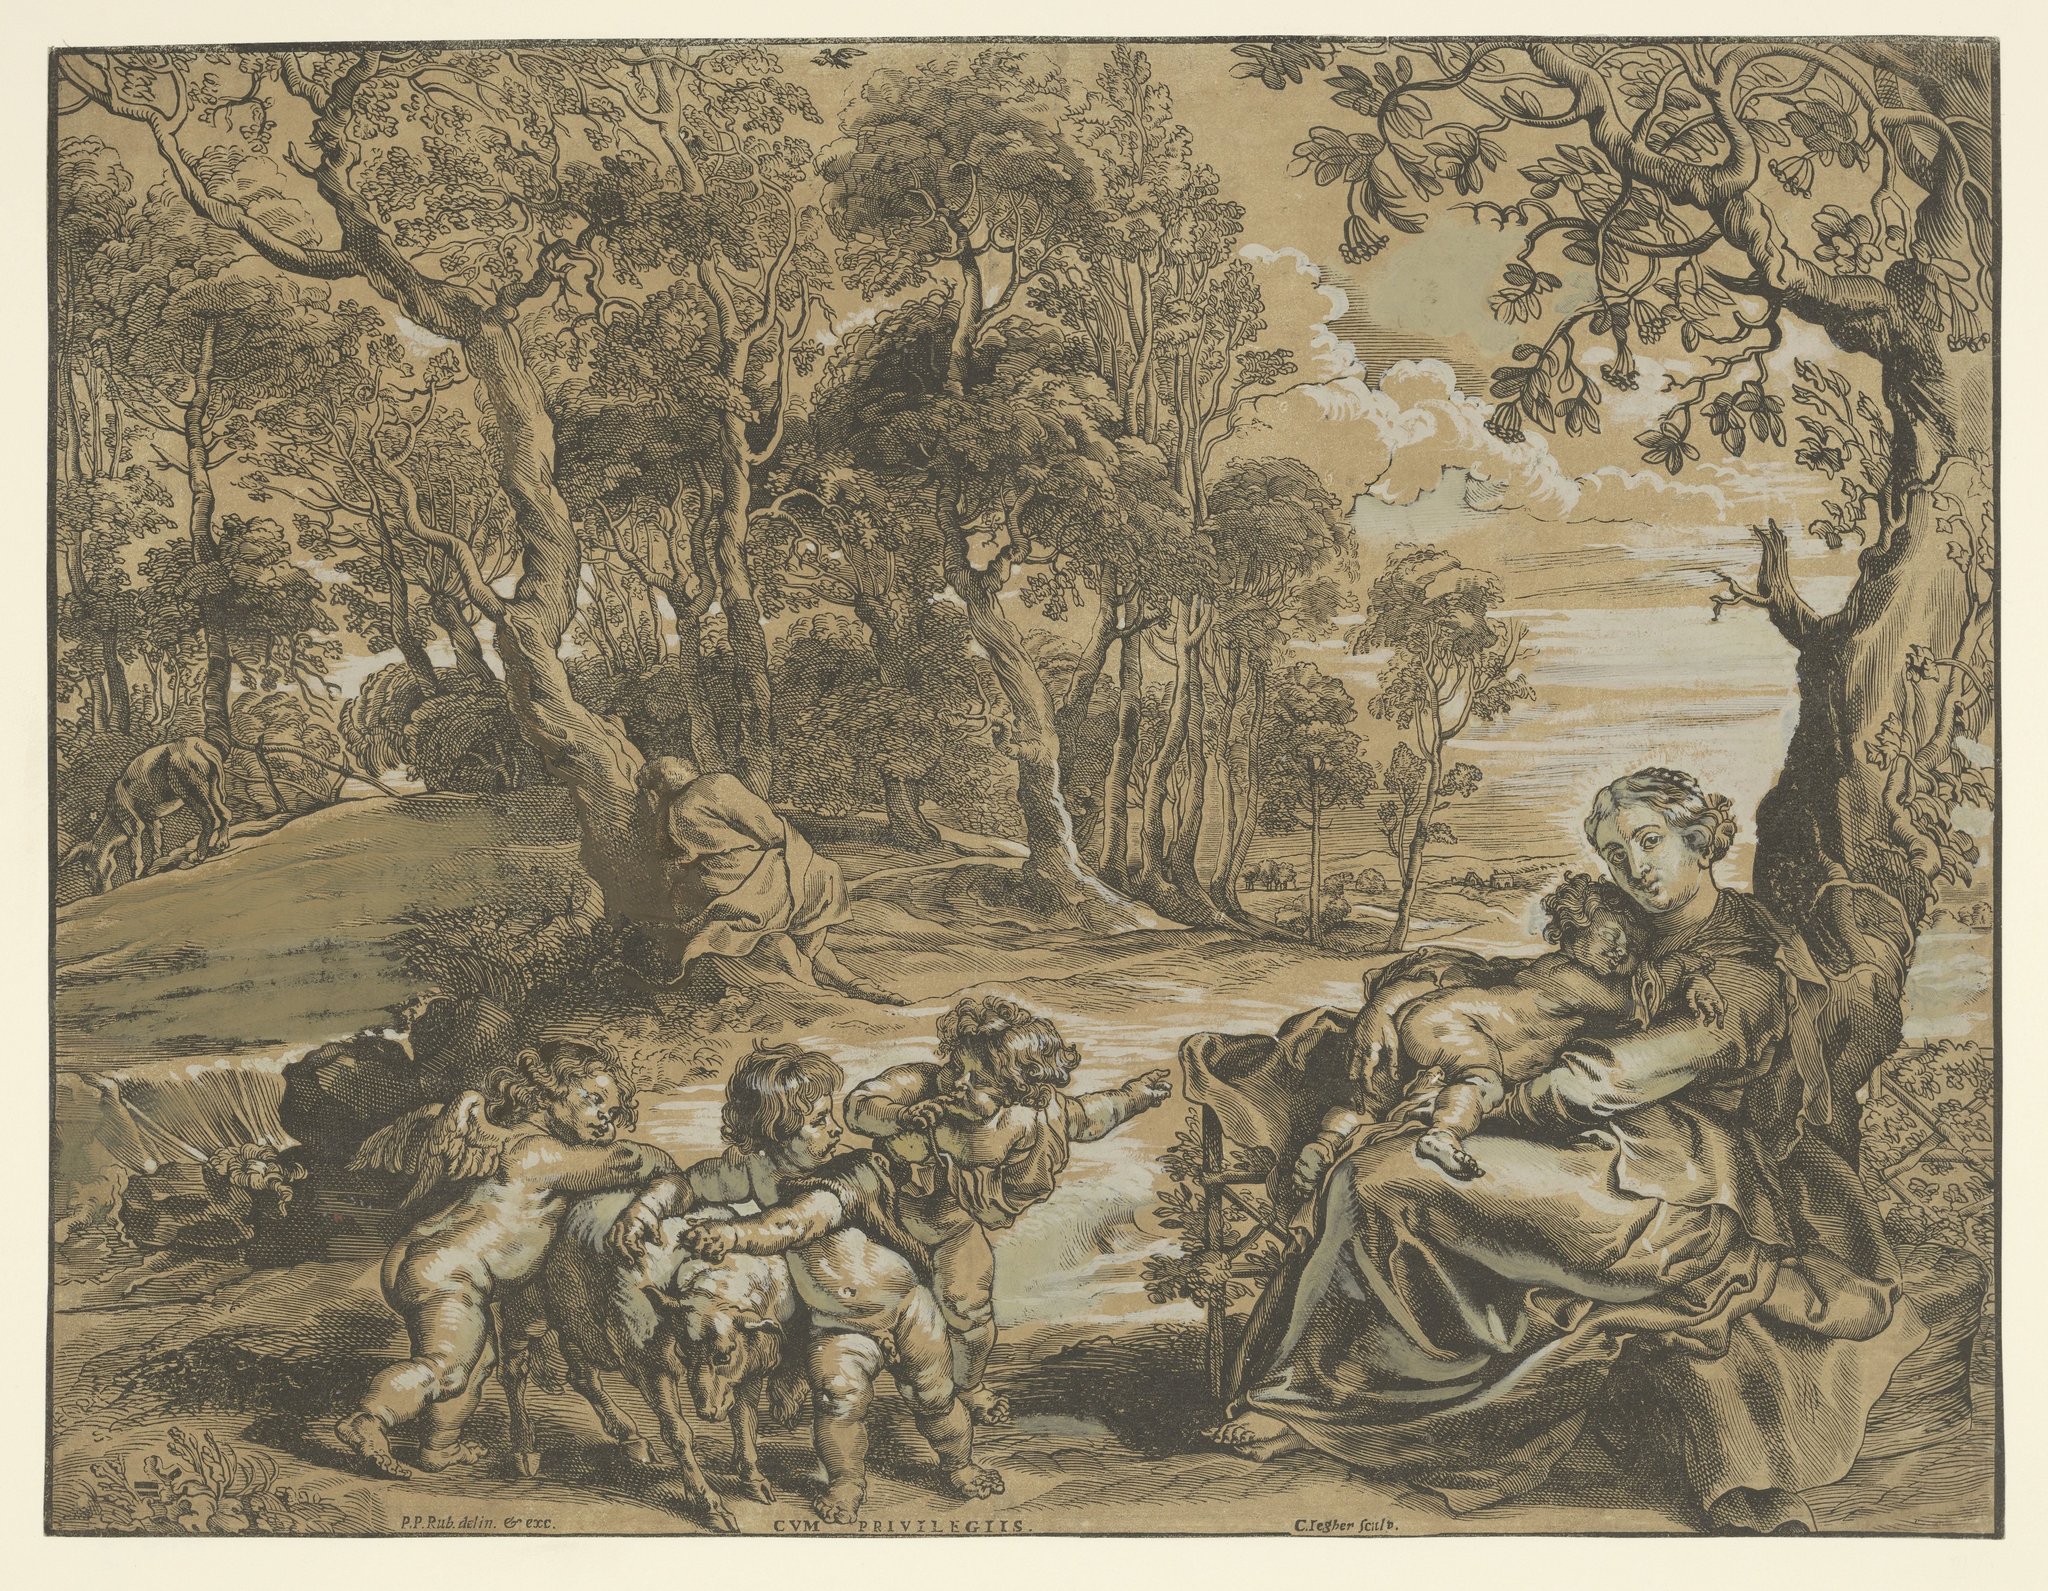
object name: print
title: Rest on the Flight into Egypt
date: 1606-1640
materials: paper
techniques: brush, woodcut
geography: southern netherlands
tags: holy family with john the baptist (as child), rest on the flight into egypt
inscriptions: collector's mark: Lugt 240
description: In addition to a host of engravers, Rubens also engaged the woodcutter Christoffel Jegher to reproduce his work. Jegher’s, often sizeable, sheets were printed in two colours and will have mostly served as wall decoration. This proof impression is printed with two blocks: a line block, and a tone block for the ochre tint. In this impression Rubens indicated with brush and wash where the white lines had to be cut away in the tone block.